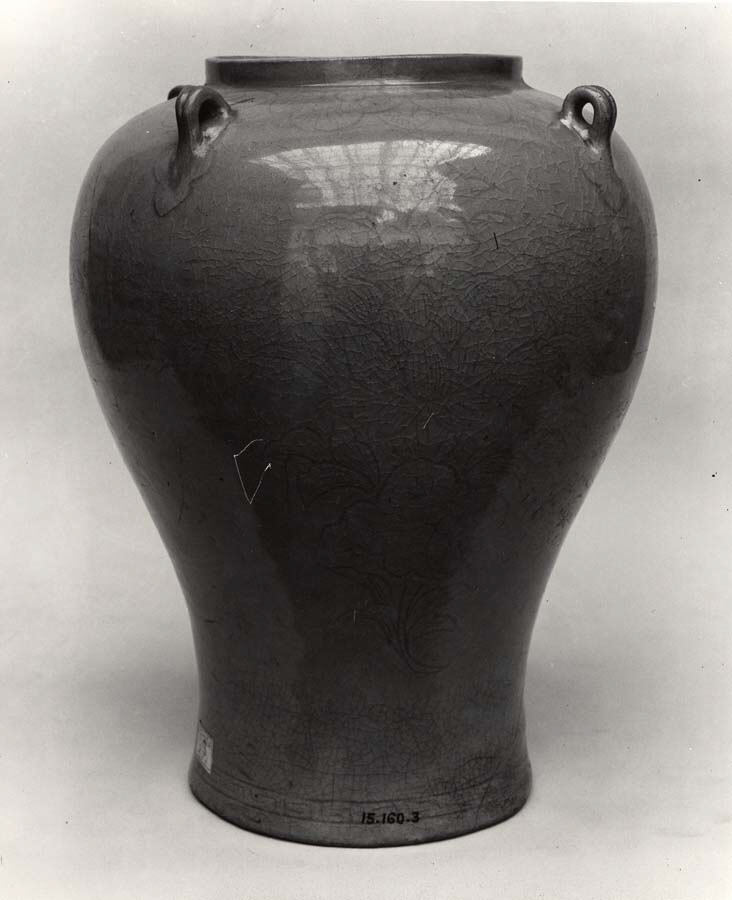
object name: jar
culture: korean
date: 1101-1150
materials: ceramic glaze, glaze, stoneware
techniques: incising